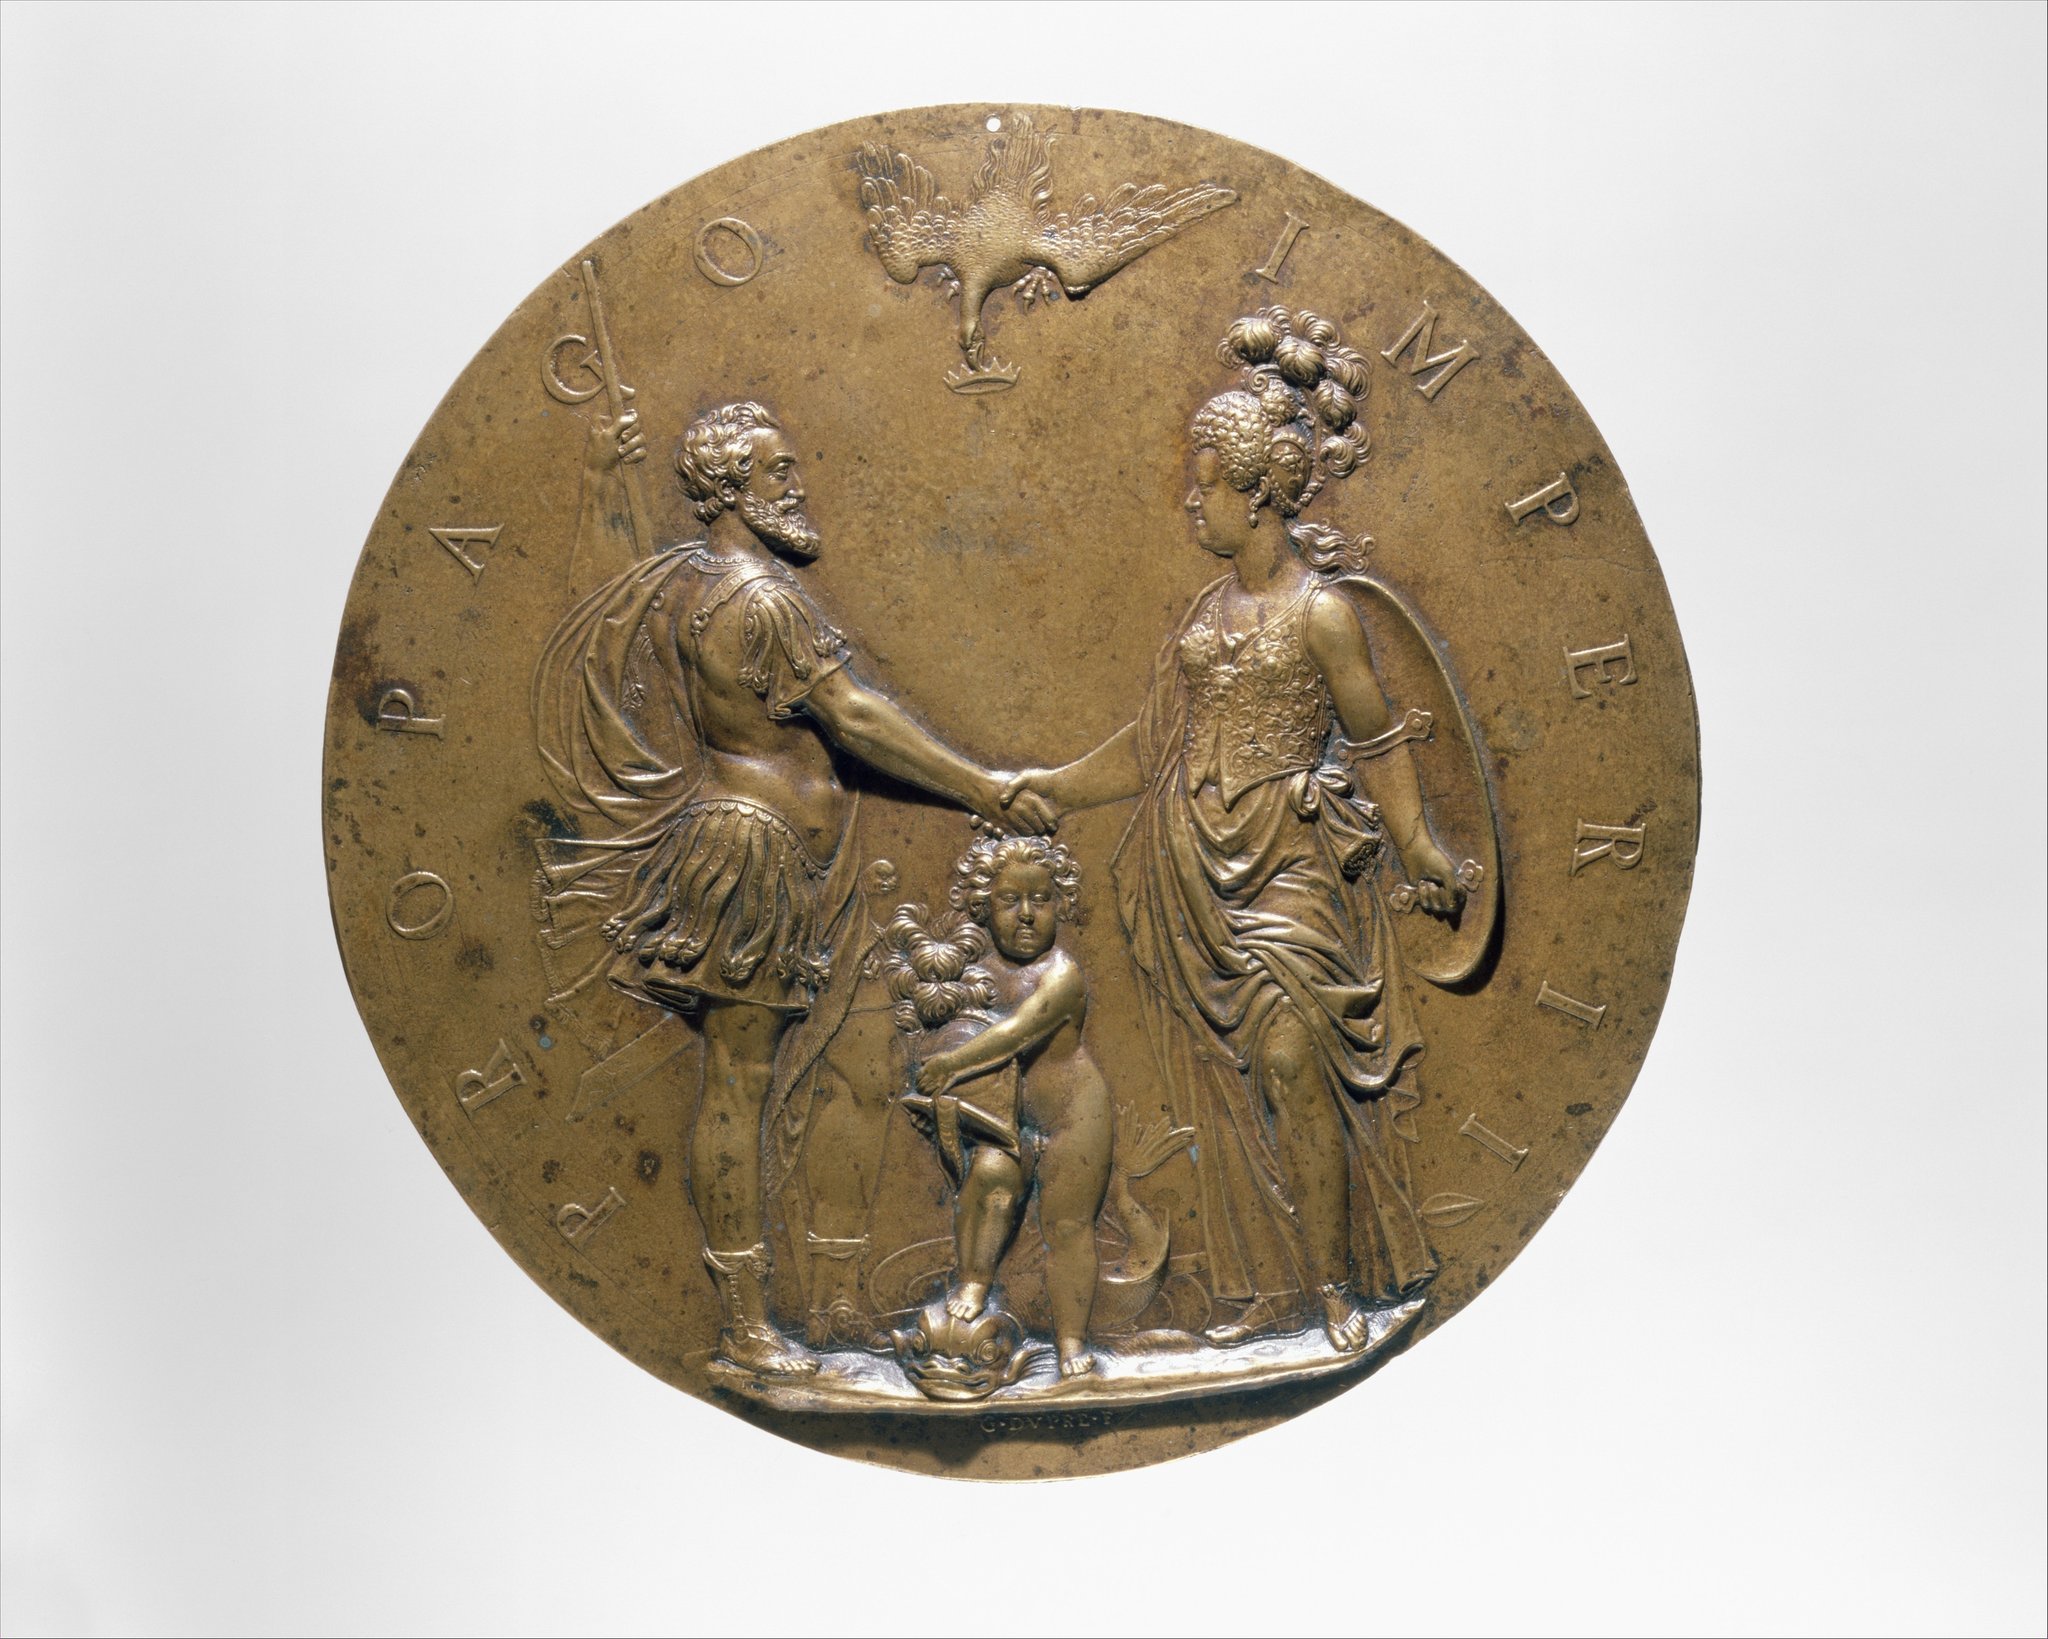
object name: medallion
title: Henri IV, Marie de Médicis and the Dauphin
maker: guillaume dupré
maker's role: artist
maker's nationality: french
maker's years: 1579-1640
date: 1605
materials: bronze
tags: birds,children,men,women